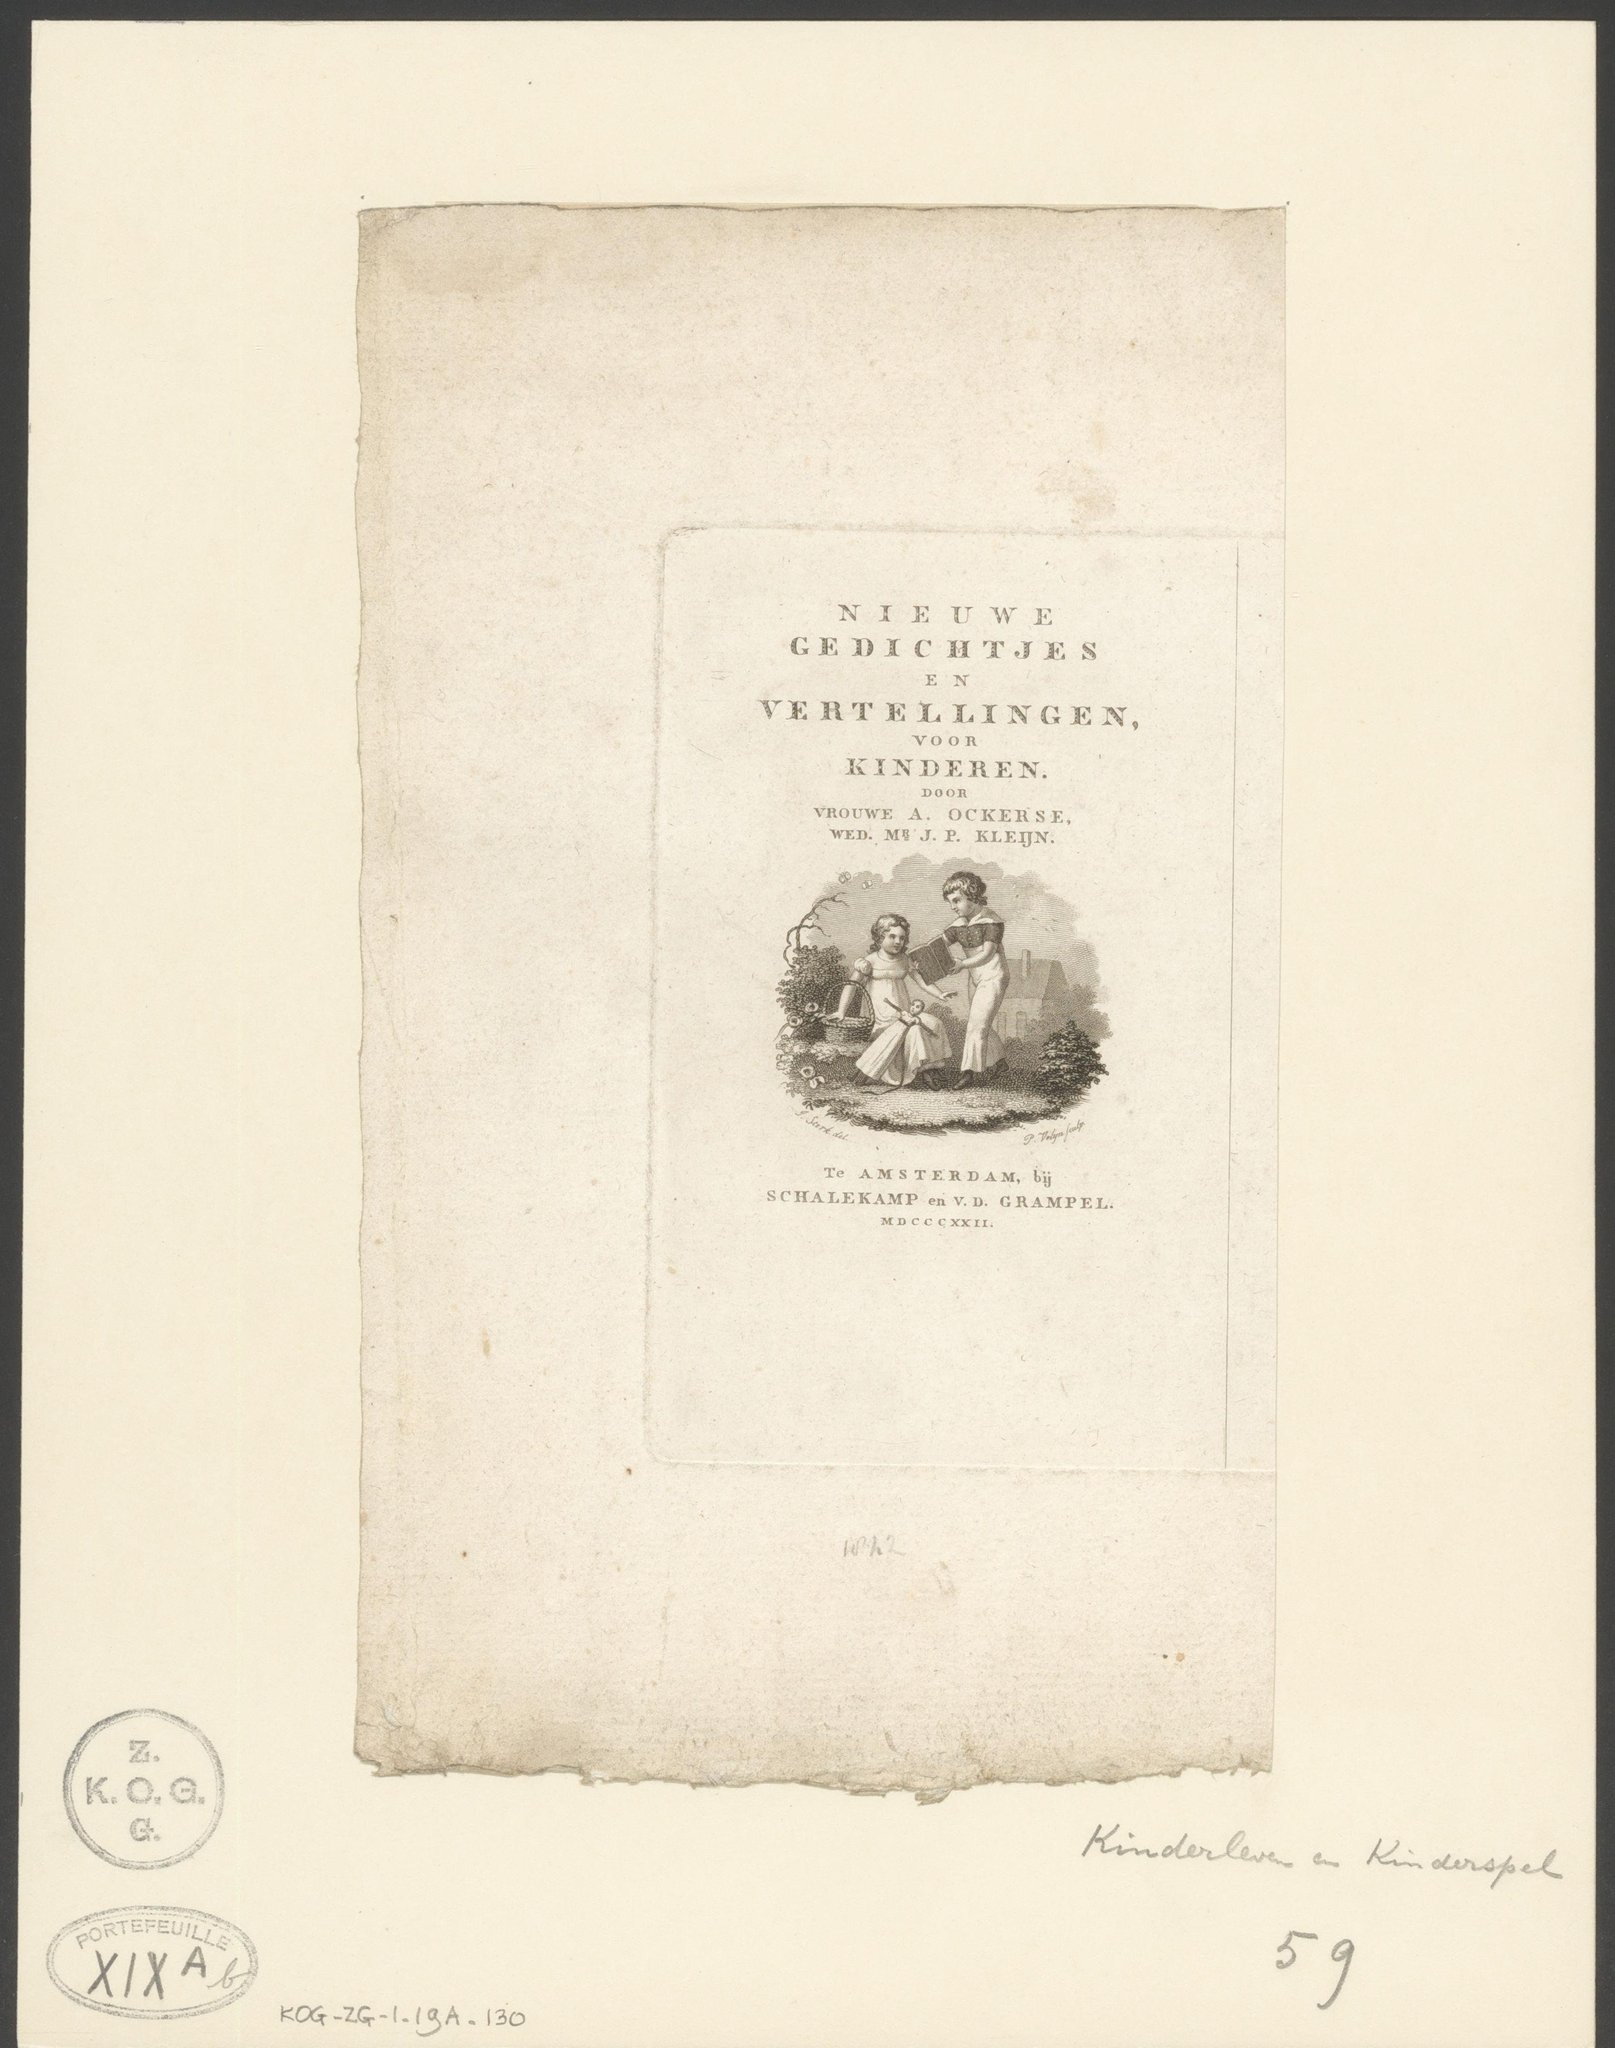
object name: titelprent, frontispice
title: Kinderen spelen bij een standbeeld van een ridder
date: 1793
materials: paper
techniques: etching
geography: amsterdam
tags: children's games and plays, reading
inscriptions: collector's mark: Lugt 1641, stamp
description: Onderwerpsrubrieken binnen de Atlas Zeden en Gewoonten: Zeden en Gewoonten in Engeren Zin, Des menschen beging, midden en einde, Kinderleven – Kinderspel en Kinderprenten.